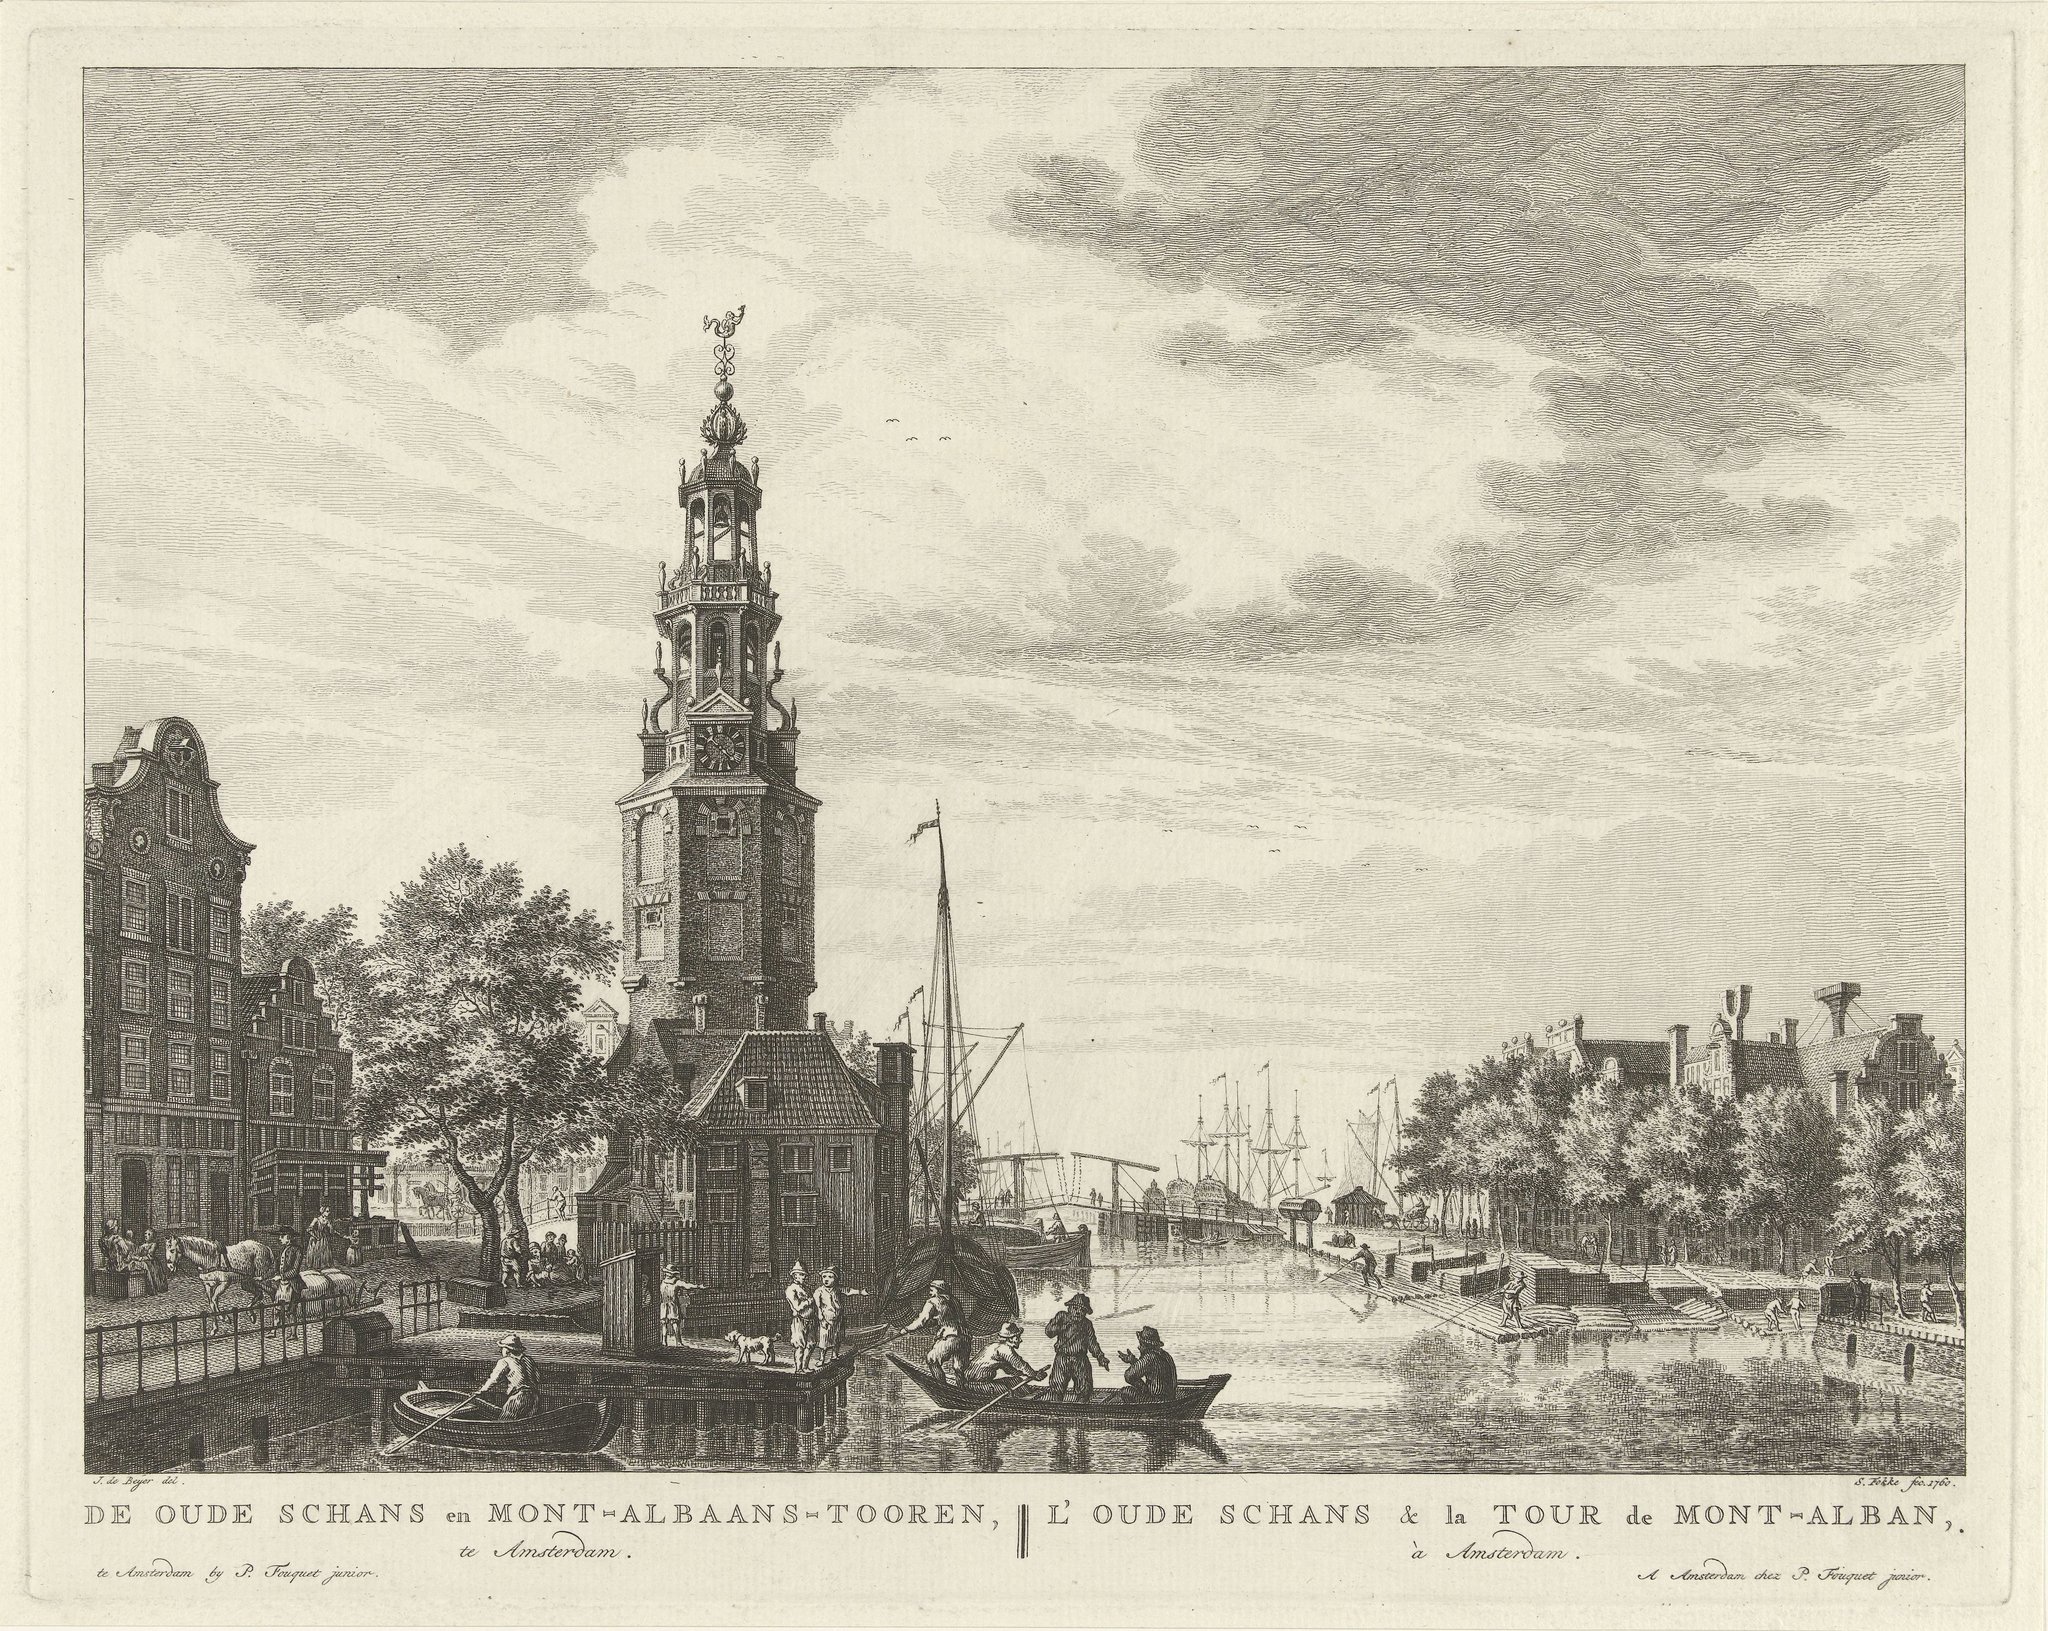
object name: print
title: De Oude Schans en Mont-Albaans-Tooren, te Amsterdam / L'Oude Schans & la Tour de Mont-Alban, à Amsterdam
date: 1760-1783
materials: paper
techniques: engraving, etching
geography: amsterdam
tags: bridge in city across river, canal, etc. (+ city(-scape) with figures, staffage), tower, clock tower ~ monumental adornment, towers ~ fortified city, canals, waters (in city) (+ city(-scape) with figures, staffage), street (+ city(-scape) with figures, staffage)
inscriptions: collector's mark: Lugt 2233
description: Deze prent is ook gebruikt in de zogenaamde Atlas van Fouquet.* Pierre Fouquet gaf vanaf 1760 stadsgezichten van Amsterdam - naar tekeningen van verschillende kunstenaars, gemaakt door verschillende prentmakers - uit. Deze prenten werden aanvankelijk los of in series verkocht. Zoals toen gebruikelijk kon de koper de prenten zelf laten inbinden. Hiertoe gaf Fouquet tussen 1778 en 1783 een titelblad, plattegrond en inhoudsopgave van de tot dusver 100 uitgegeven prenten uit (1). Gezien de inhoud afhankelijk was van wat de koper had verzameld verschilt de inhoud van de verschillende bewaarde Fouquetatlassen onder deze titel sterk. Ook zijn er exemplaren bekend waar tevens andere prenten aan zijn toegevoegd. Omdat er behoefte bleek aan uitleg bij de platen werd in 1783 een nieuwe versie van de atlas uitgegeven, aangevuld met tekst en twee prenten. De aangegeven volgorde veranderde maar de platen van de al eerder uitgegeven prenten bleven ongewijzigd. Deze uitgave werd in opdracht van Fouquet gedrukt bij Daniël Jean Changuion en Petrus den Hengst (2). Een tiental platen werd bijgewerkt en verscheen, met nieuw impressum, in het vervolg van Wagenaars geschiedenis van Amsterdam, uitgeven door Petrus Conradi en Folkert van der Plaats (3). Een aantal jaar na het overlijden van Fouquet kwam Evert Maaskamp met een nieuwe uitgave van de atlas, met verbeterde tekst en toevoeging van twee prenten. Op alle platen verwijderde hij het oude en liet hij zijn eigen impressum zetten (4). De huidige staat van de prent komt voor in exemplaren van de onder (1) en (2) genoemde werken. * Onder de Atlas van Fouquet of Fouquetatlas verstaan we de hieronder vermelde publicaties (1), (2) en (4). (1). Afbeeldingen van de wyd-vermaarde koopstad Amsterdam benevens des zelvs voornaamste gebouwen en gezigten alle naar het leeven getekend / Receuil des edifices les plus considerables et des plus belles vues, de la fameuse ville d'Amsterdam, dessinées d'après nature. Amsterdam: Pierre Fouquet, 1778-1783. (2). Nieuwe atlas, van de voornaamste gebouwen en gezigten der stad Amsterdam, met derzelver beknopte beschryvingen. 2 delen. Amsterdam: Daniël Jean Changuion en Petrus den Hengst [in opdracht van Pierre Fouquet], 1783. (3). Stijl, Simon. Amsterdam, in zyne geschiedenissen, voorregten, koophandel, gebouwen, kerkenstaat, schoolen, schutterye, gilden en regeeringe, beschreeven. Om te dienen ten vervolge op het werk van Jan Wagenaar (…). 10 delen. Amsterdam en Harlingen: Petrus Conradi en Folkert van der Plaats, 1788-1801. (4). Nieuwe atlas, van de voornaamste gebouwen en gezigten der stad Amsterdam. Met derzelver beknopte beschryvingen. Amsterdam: Evert Maaskamp, 1805. * Het aantal vermelde staten is gebaseerd op het aantal gevonden staten. Mogelijk zijn er meer staten van deze prent. Vermoedelijke eerste staat in collectie van TU Delft met Paulus van Liender vermeld als prentmaker. Vermoedelijke derde staat, zie KOG-AA-1-13-5. Vermoedelijke vierde staat, zie RP-P-1905-399. Vermoedelijke vijfde staat, zie KOG-AA-1-29-68. Vermoedelijke laatste staat met adres van Maaskamp.